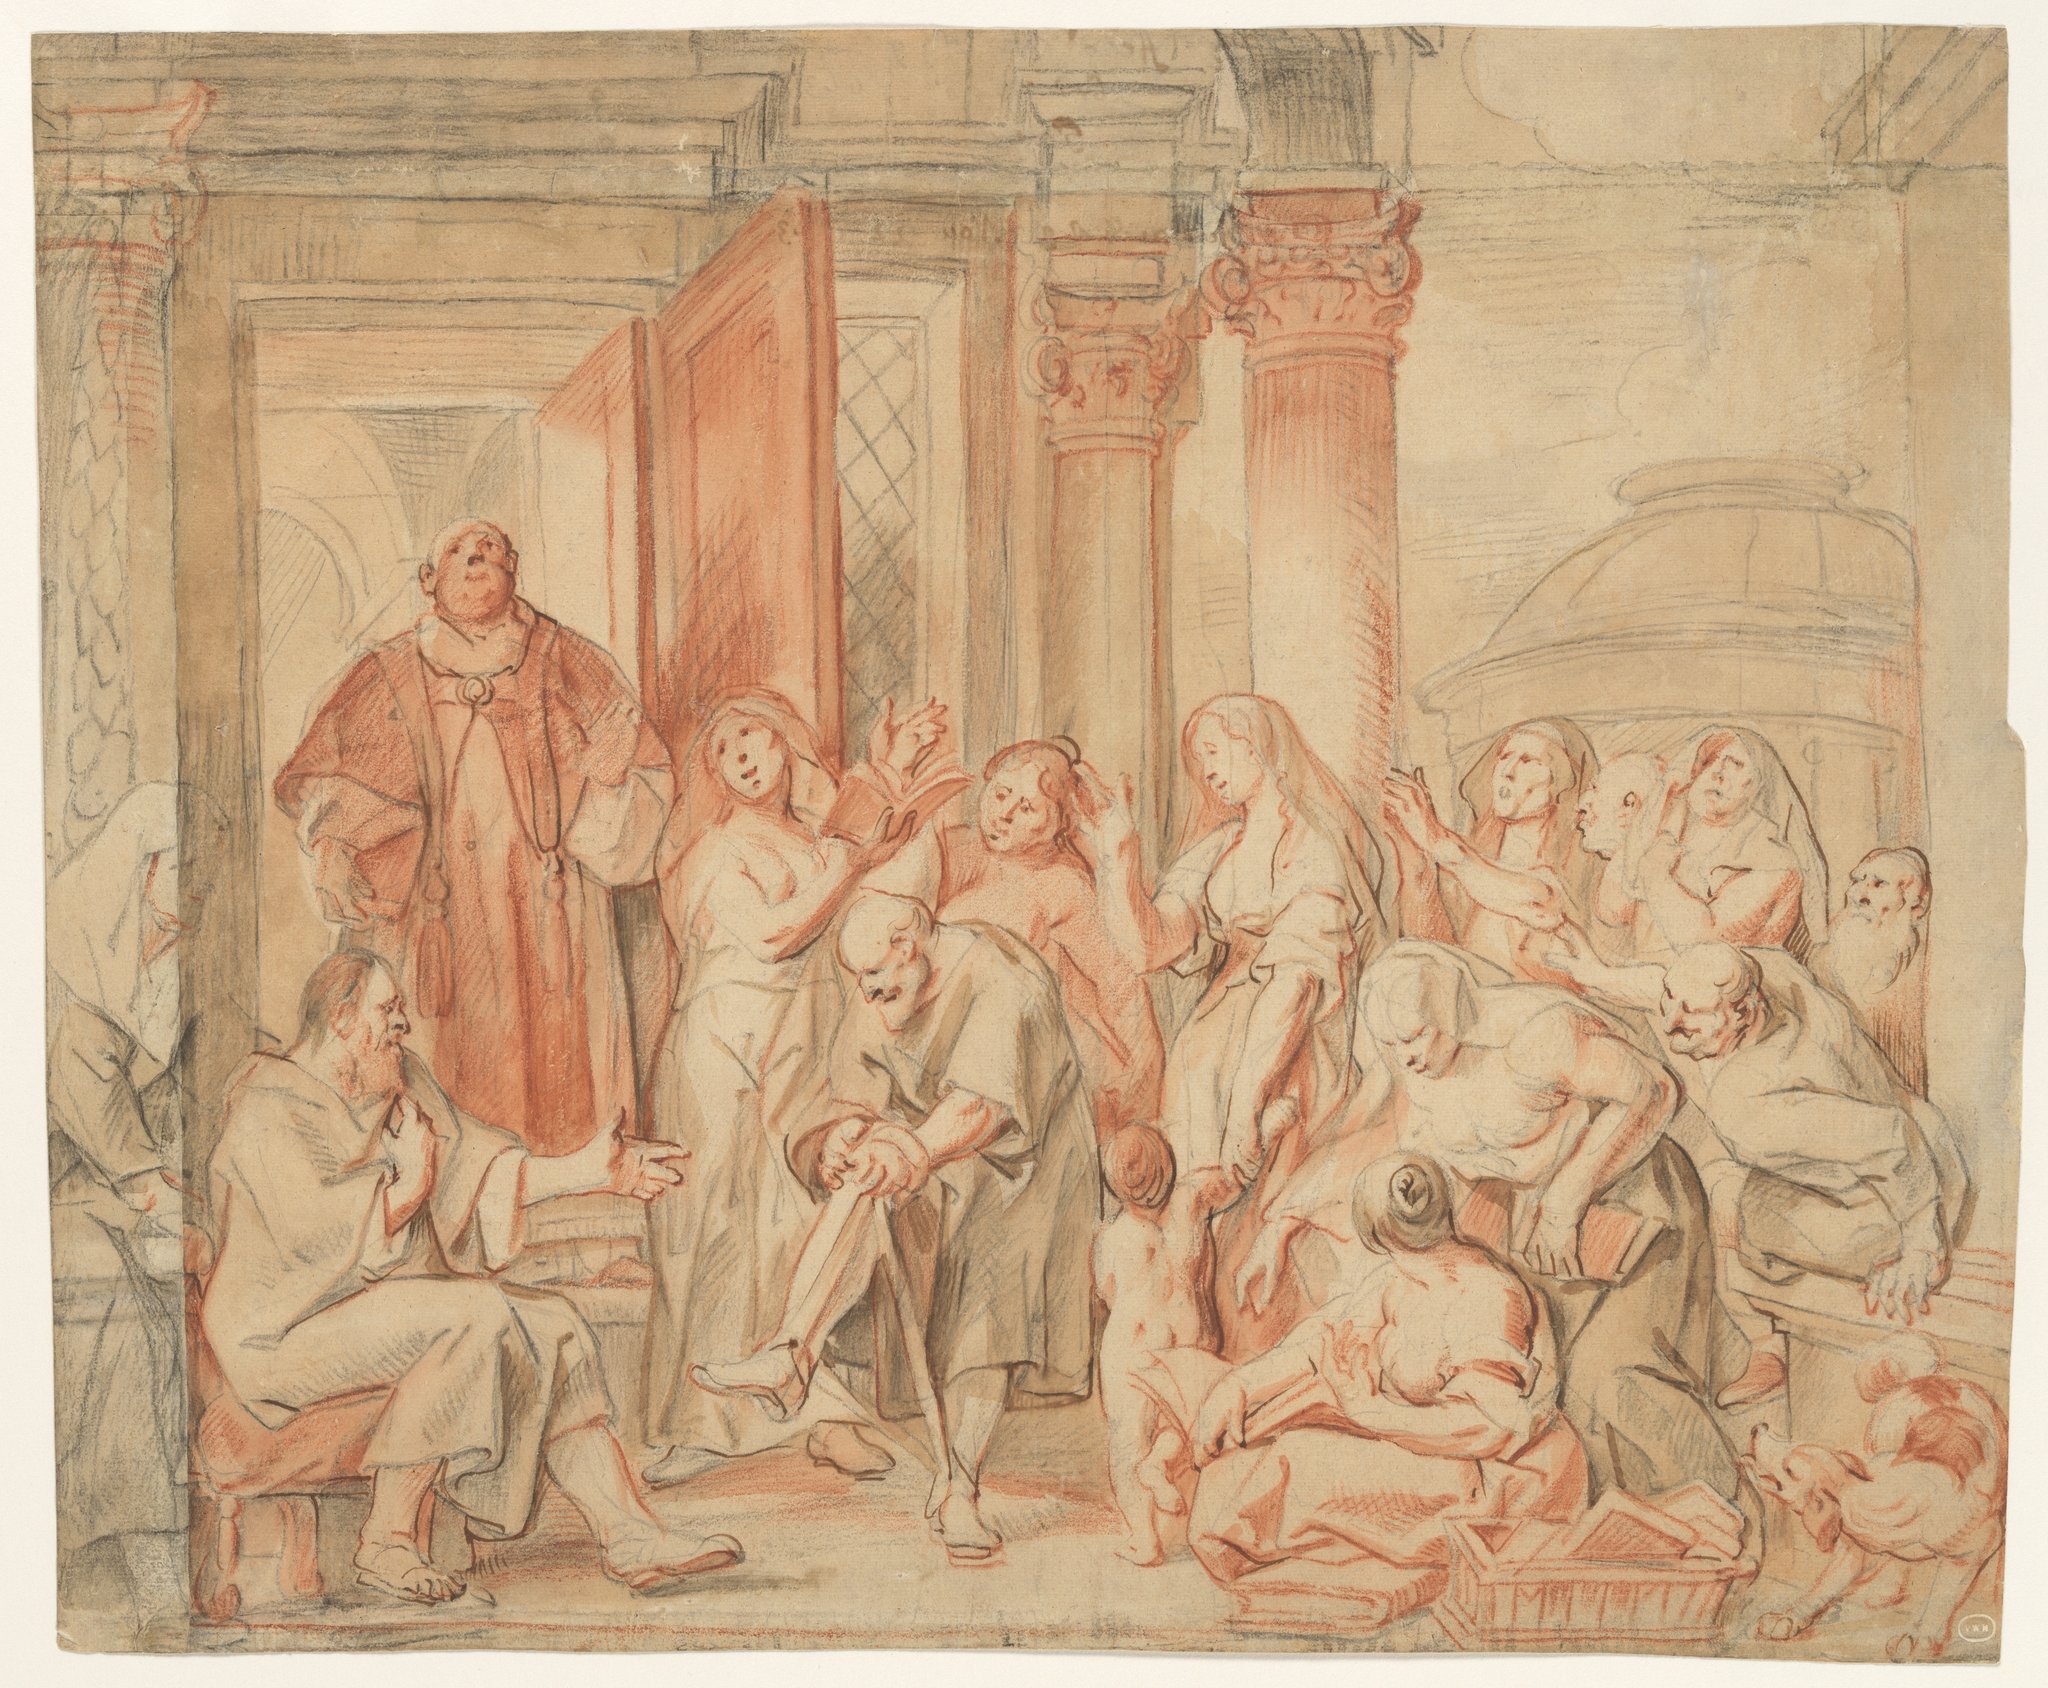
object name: drawing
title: Saint Philip Healing the Cripple in Samaria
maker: jacob jordaens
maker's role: artist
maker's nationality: flemish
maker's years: 1593-1678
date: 1655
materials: chalk, paper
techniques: wash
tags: men,women,dogs,saints